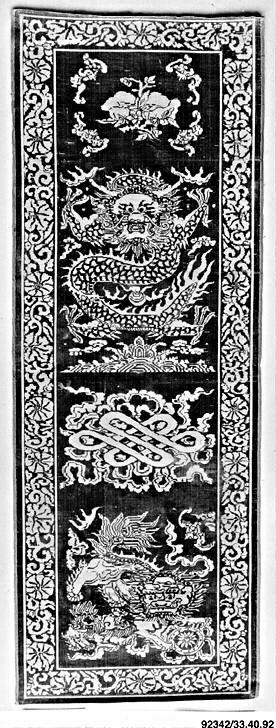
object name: chair strip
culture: chinese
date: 1801-1900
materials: velvet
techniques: cutting, voiding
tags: dragons